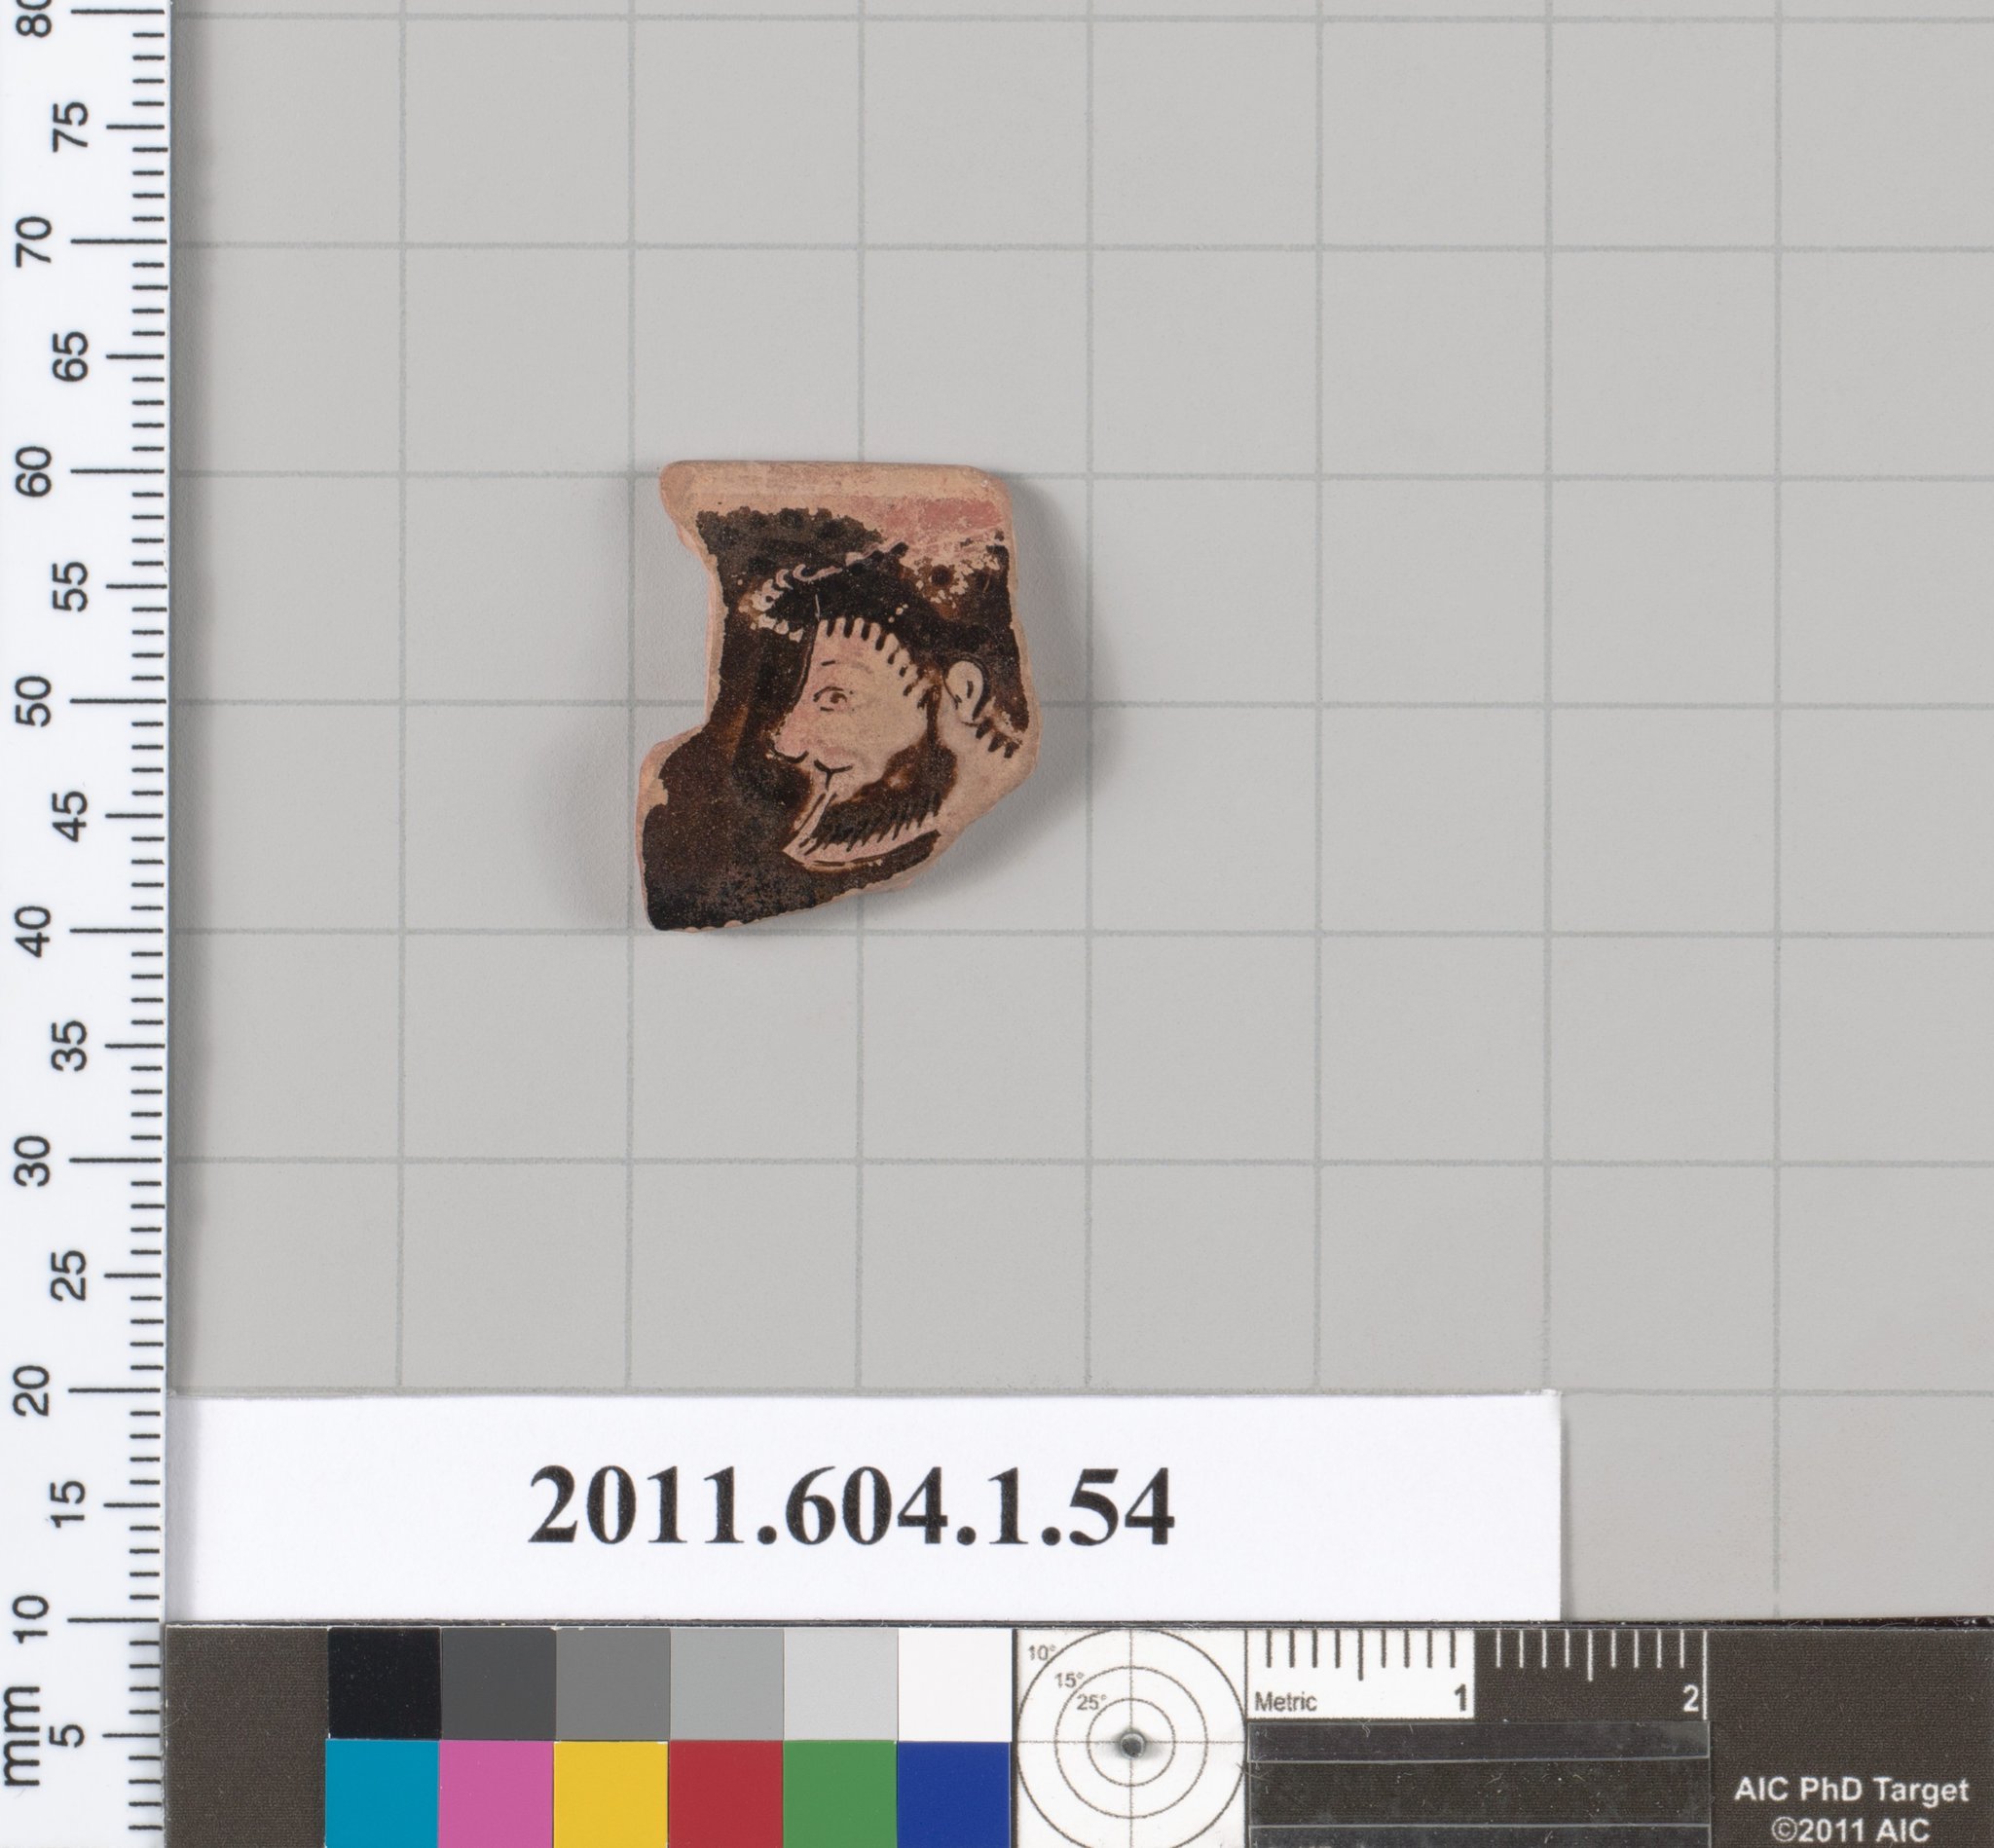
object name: kylix fragment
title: Terracotta rim fragment of a kylix (drinking cup)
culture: greek, attic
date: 500 BCE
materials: terracotta